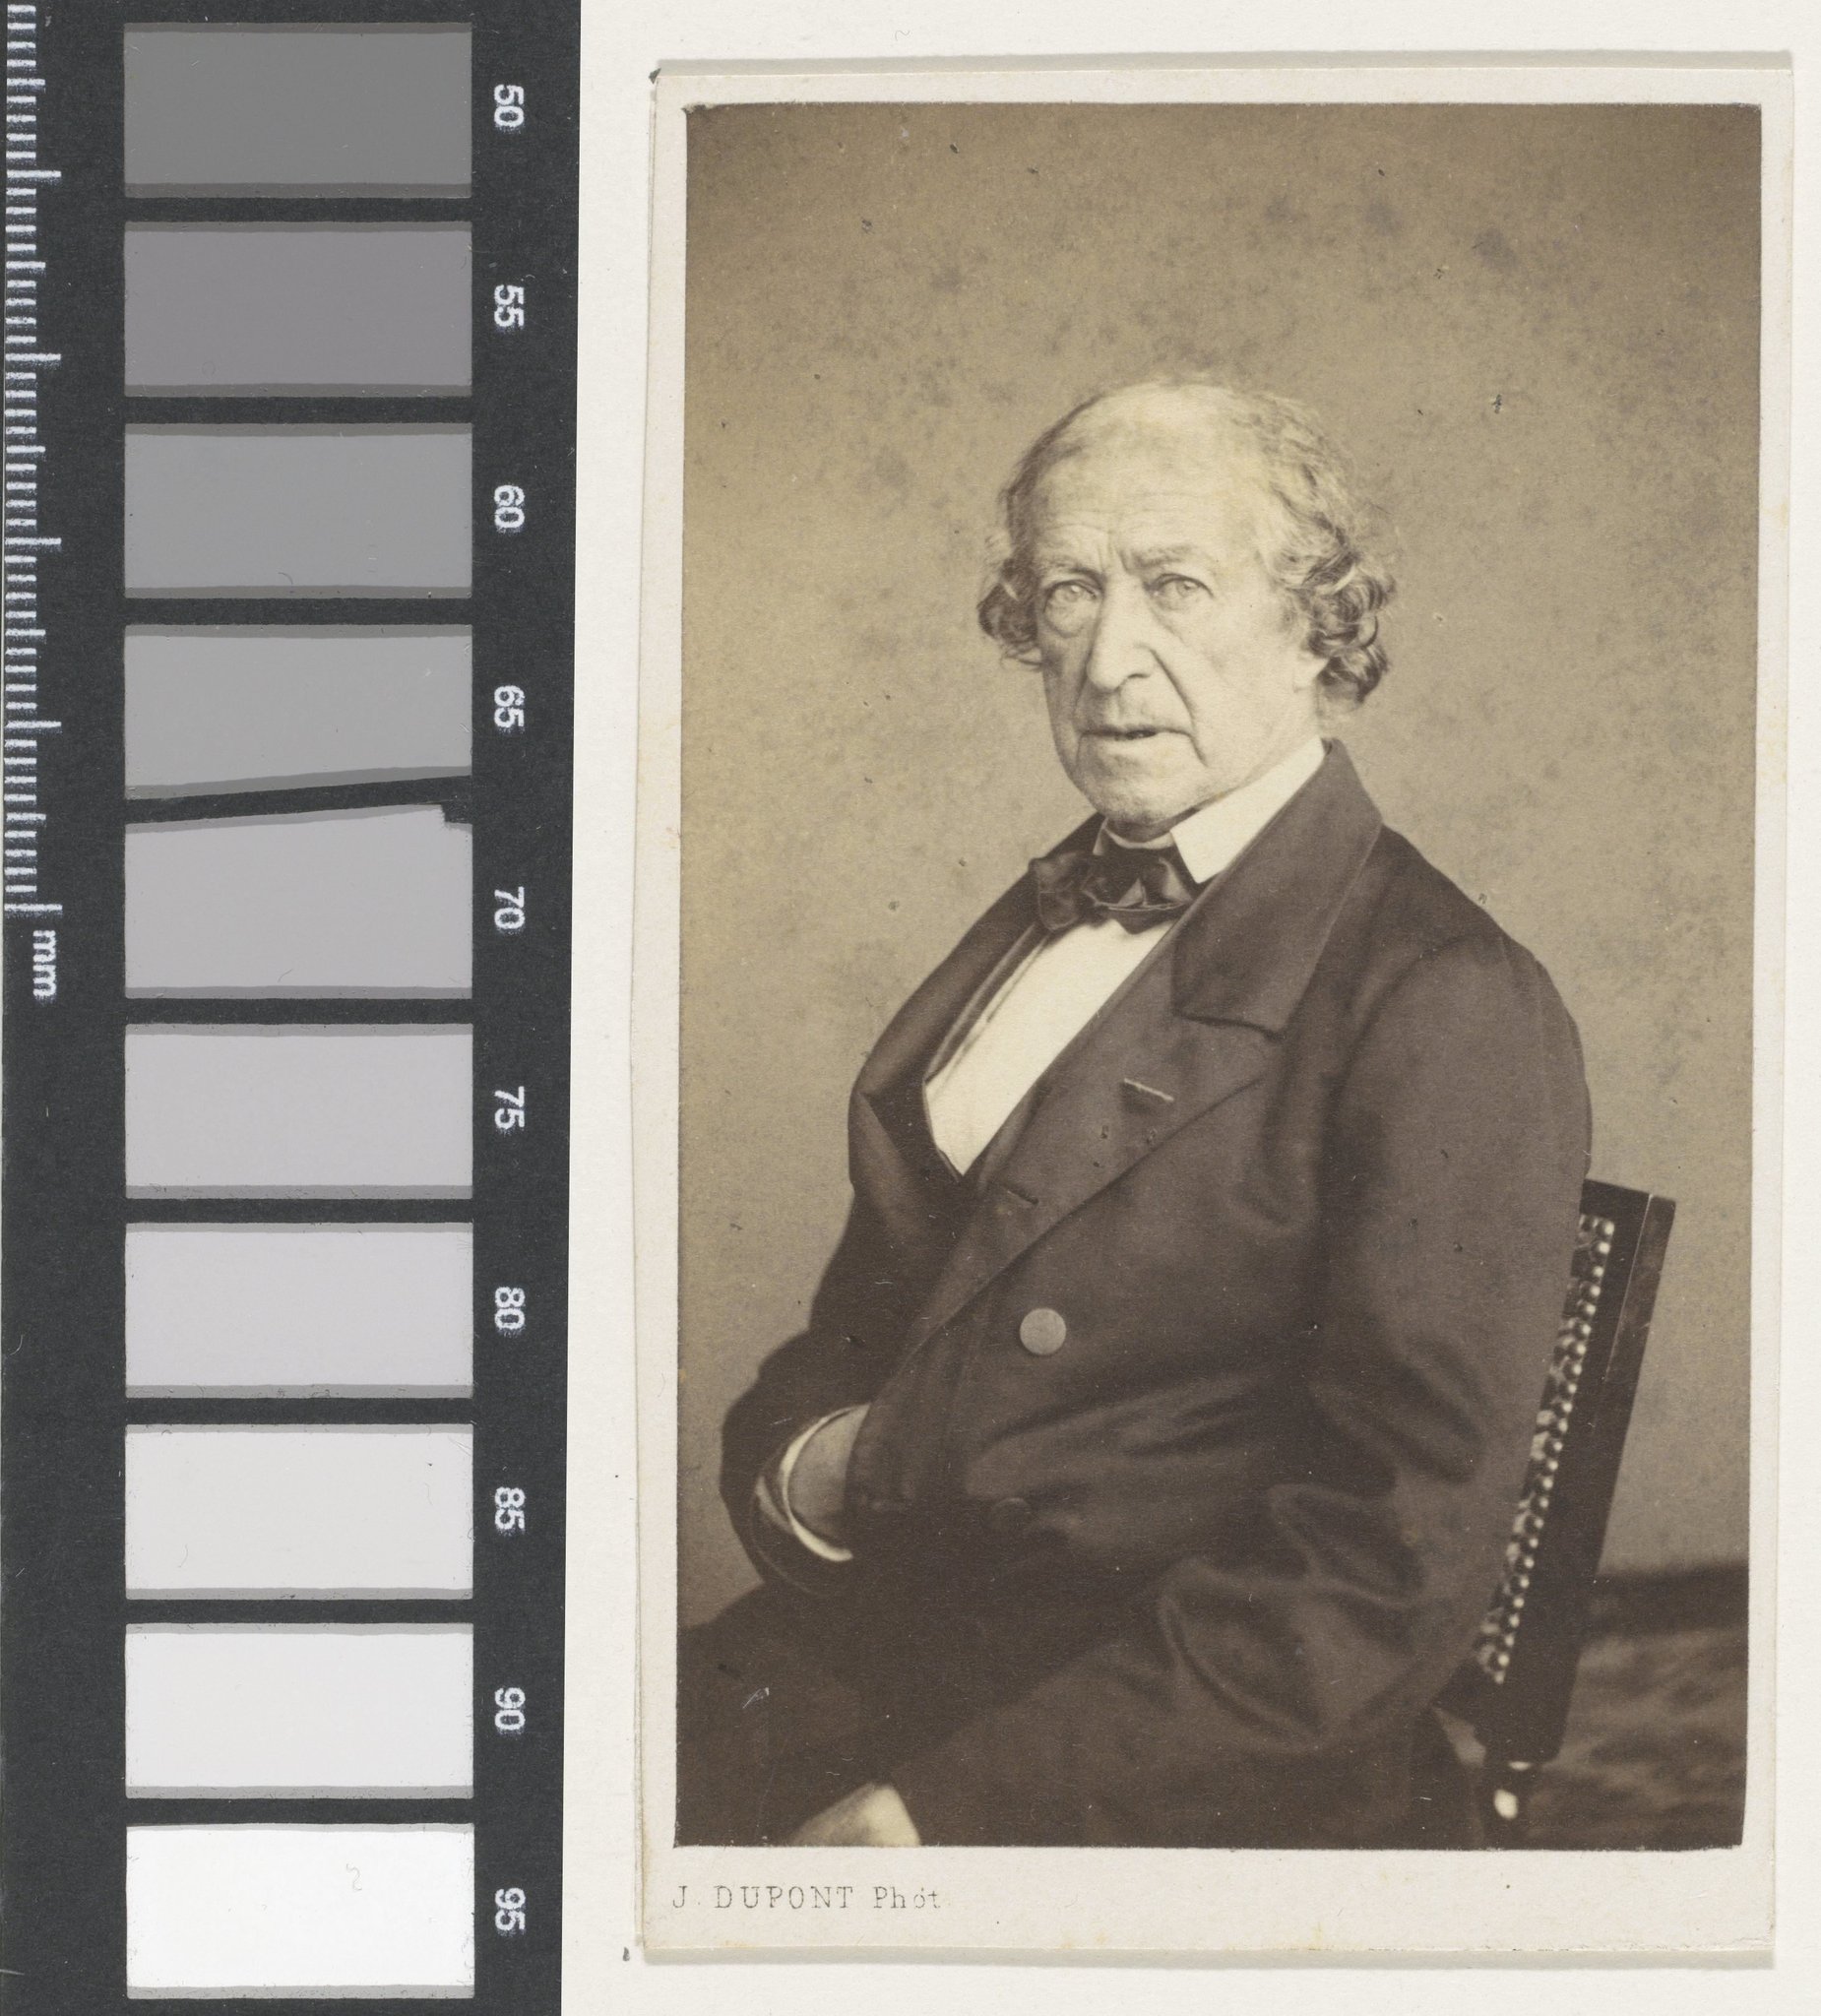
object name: photograph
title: Portret van de schilder Philippe-Jacques van Bree, halffiguur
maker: joseph dupont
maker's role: fotograaf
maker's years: 1818-1901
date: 1861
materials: cardboard, paper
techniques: albumen print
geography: antwerp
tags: antwerp, print maker, draughtsman, philippus jacobus van bree, historical persons, portrait, self-portrait of painter, portrait, self-portrait of artist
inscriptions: inscription: ‘ETABLISSEMENT PHOTOGRAPHIQUE/ de/ J. DUPONT/ Place de Meir 32/ ANVERS/ Maison fondée en 1853’, inscription: ‘van Bree (Ph)/ peintre d'histoire’